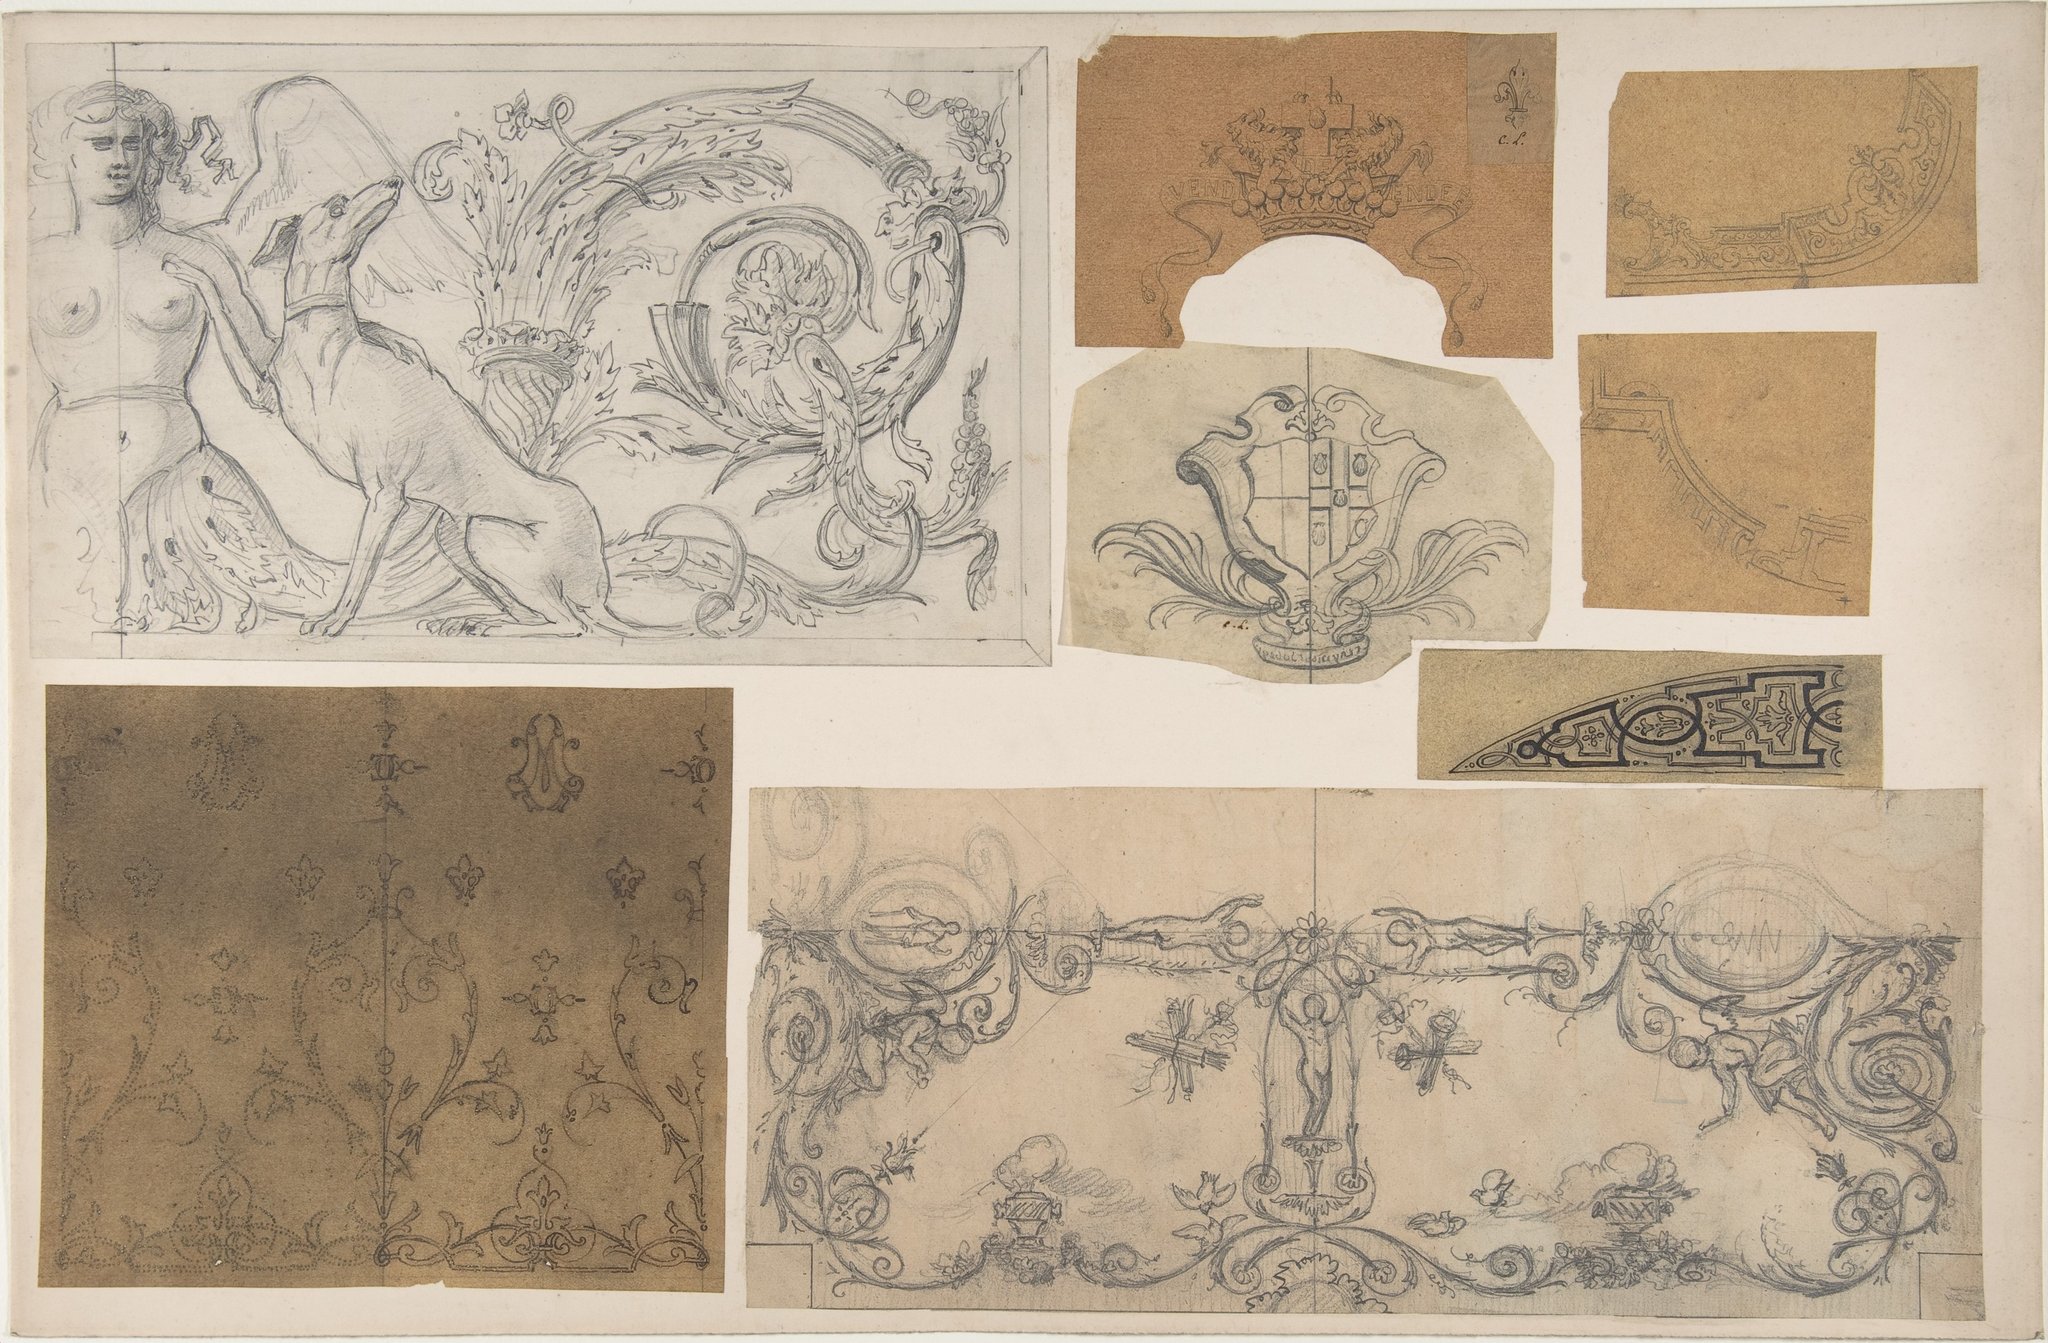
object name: drawing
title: Eight Miscellaneous Designs for the de la Rochejaquelein Family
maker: jules-edmond-charles lachaise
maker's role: artist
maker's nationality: french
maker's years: 1897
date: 1851-1900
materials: graphite, ink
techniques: pen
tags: shields,cartouches,female nudes,dogs